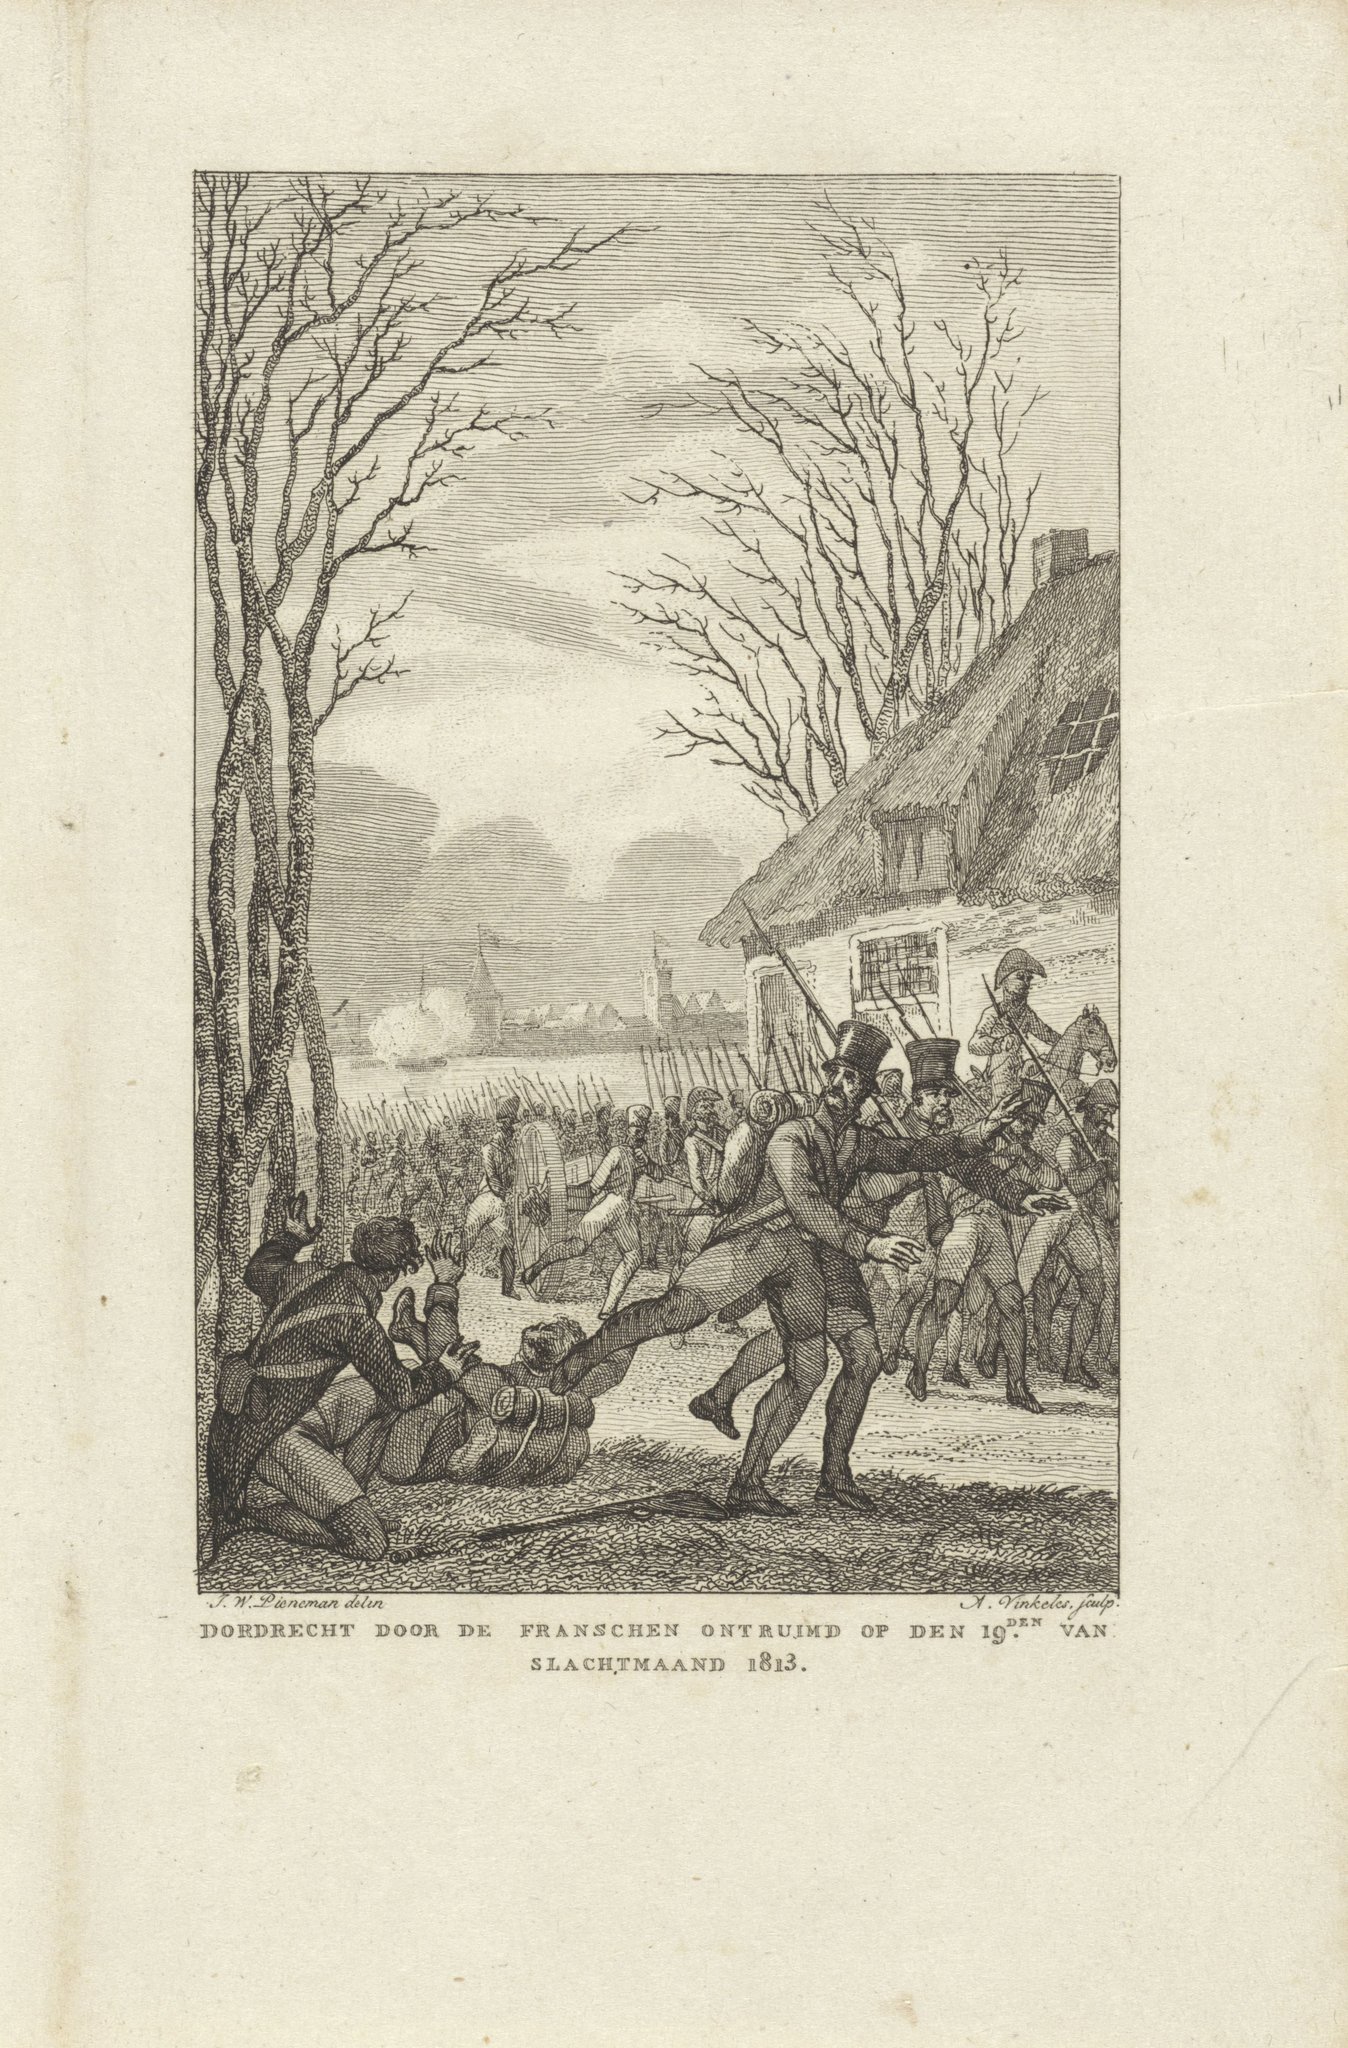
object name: history print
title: Dordrecht door de Franschen ontruimd op den 19den van Slachtmaand 1813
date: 1816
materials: paper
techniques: engraving, etching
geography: amsterdam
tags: attack ~ siege, dordrecht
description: prent gebruikt in: Konijnburg, J. Nationaal gedenkboek der hernieuwde Nederlandsche unie van den jare 1813 : met platen en portretten. Den Haag: Johannes Allart, 1816.